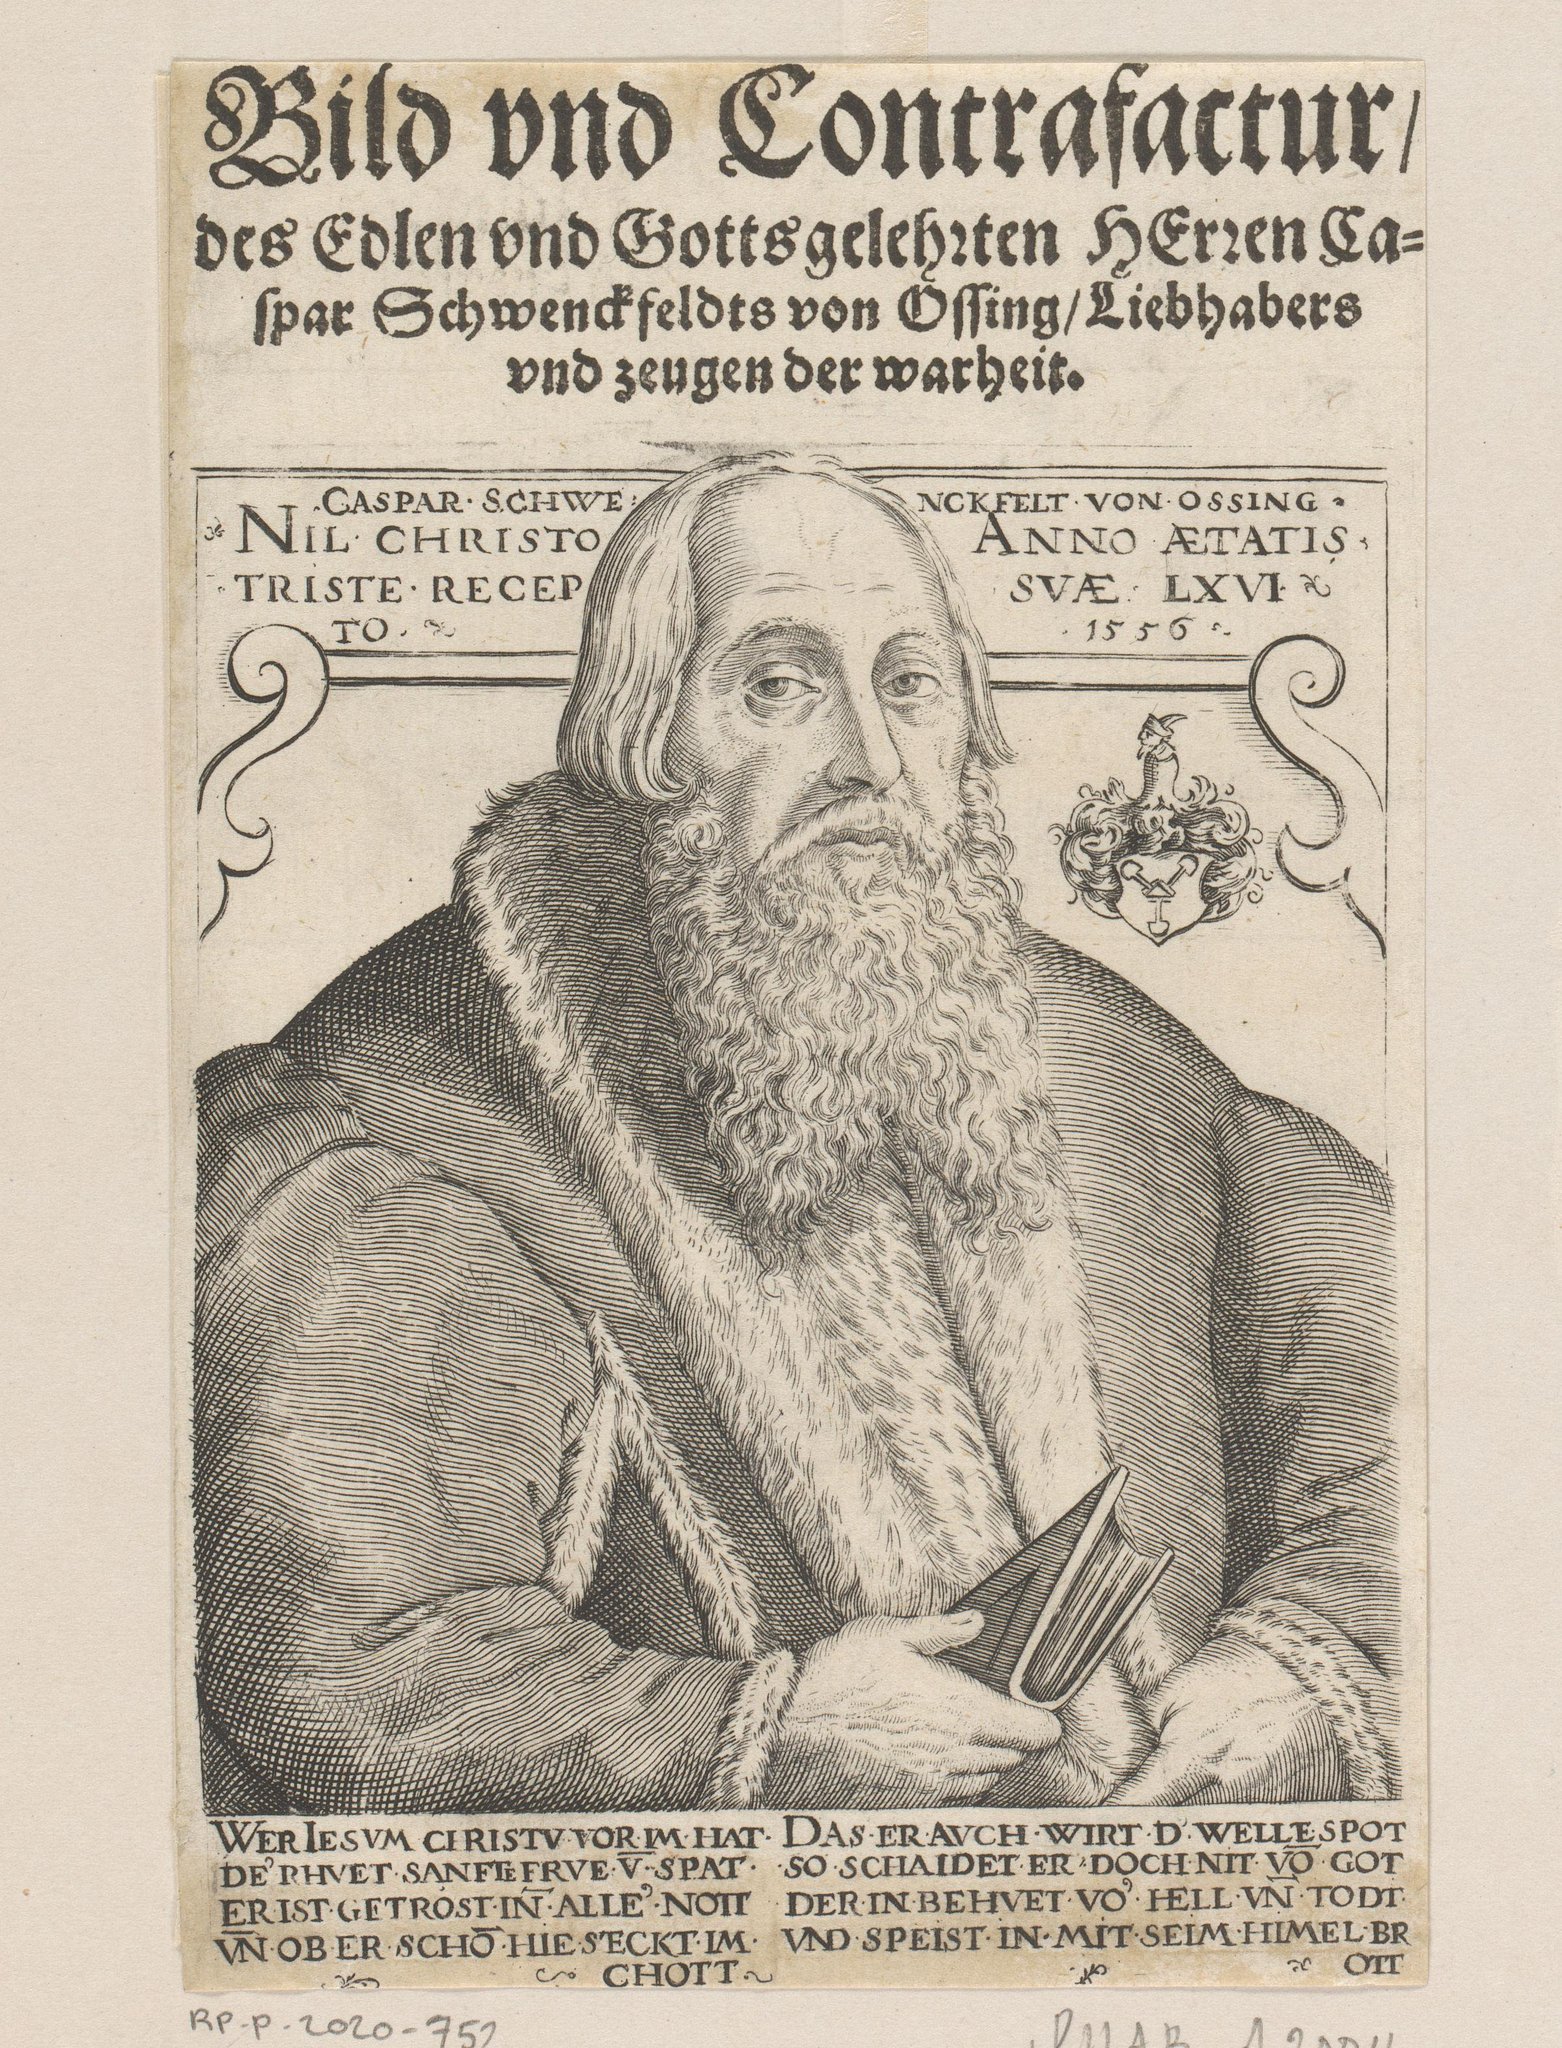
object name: print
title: Portret van Kaspar von Schwenkfeld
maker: Anonymous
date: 1556-1599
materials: paper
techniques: engraving, letterpress printing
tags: theologian, historical persons, book, armorial bearing, heraldry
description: Met rechts naast het hoofd zijn wapenschild.